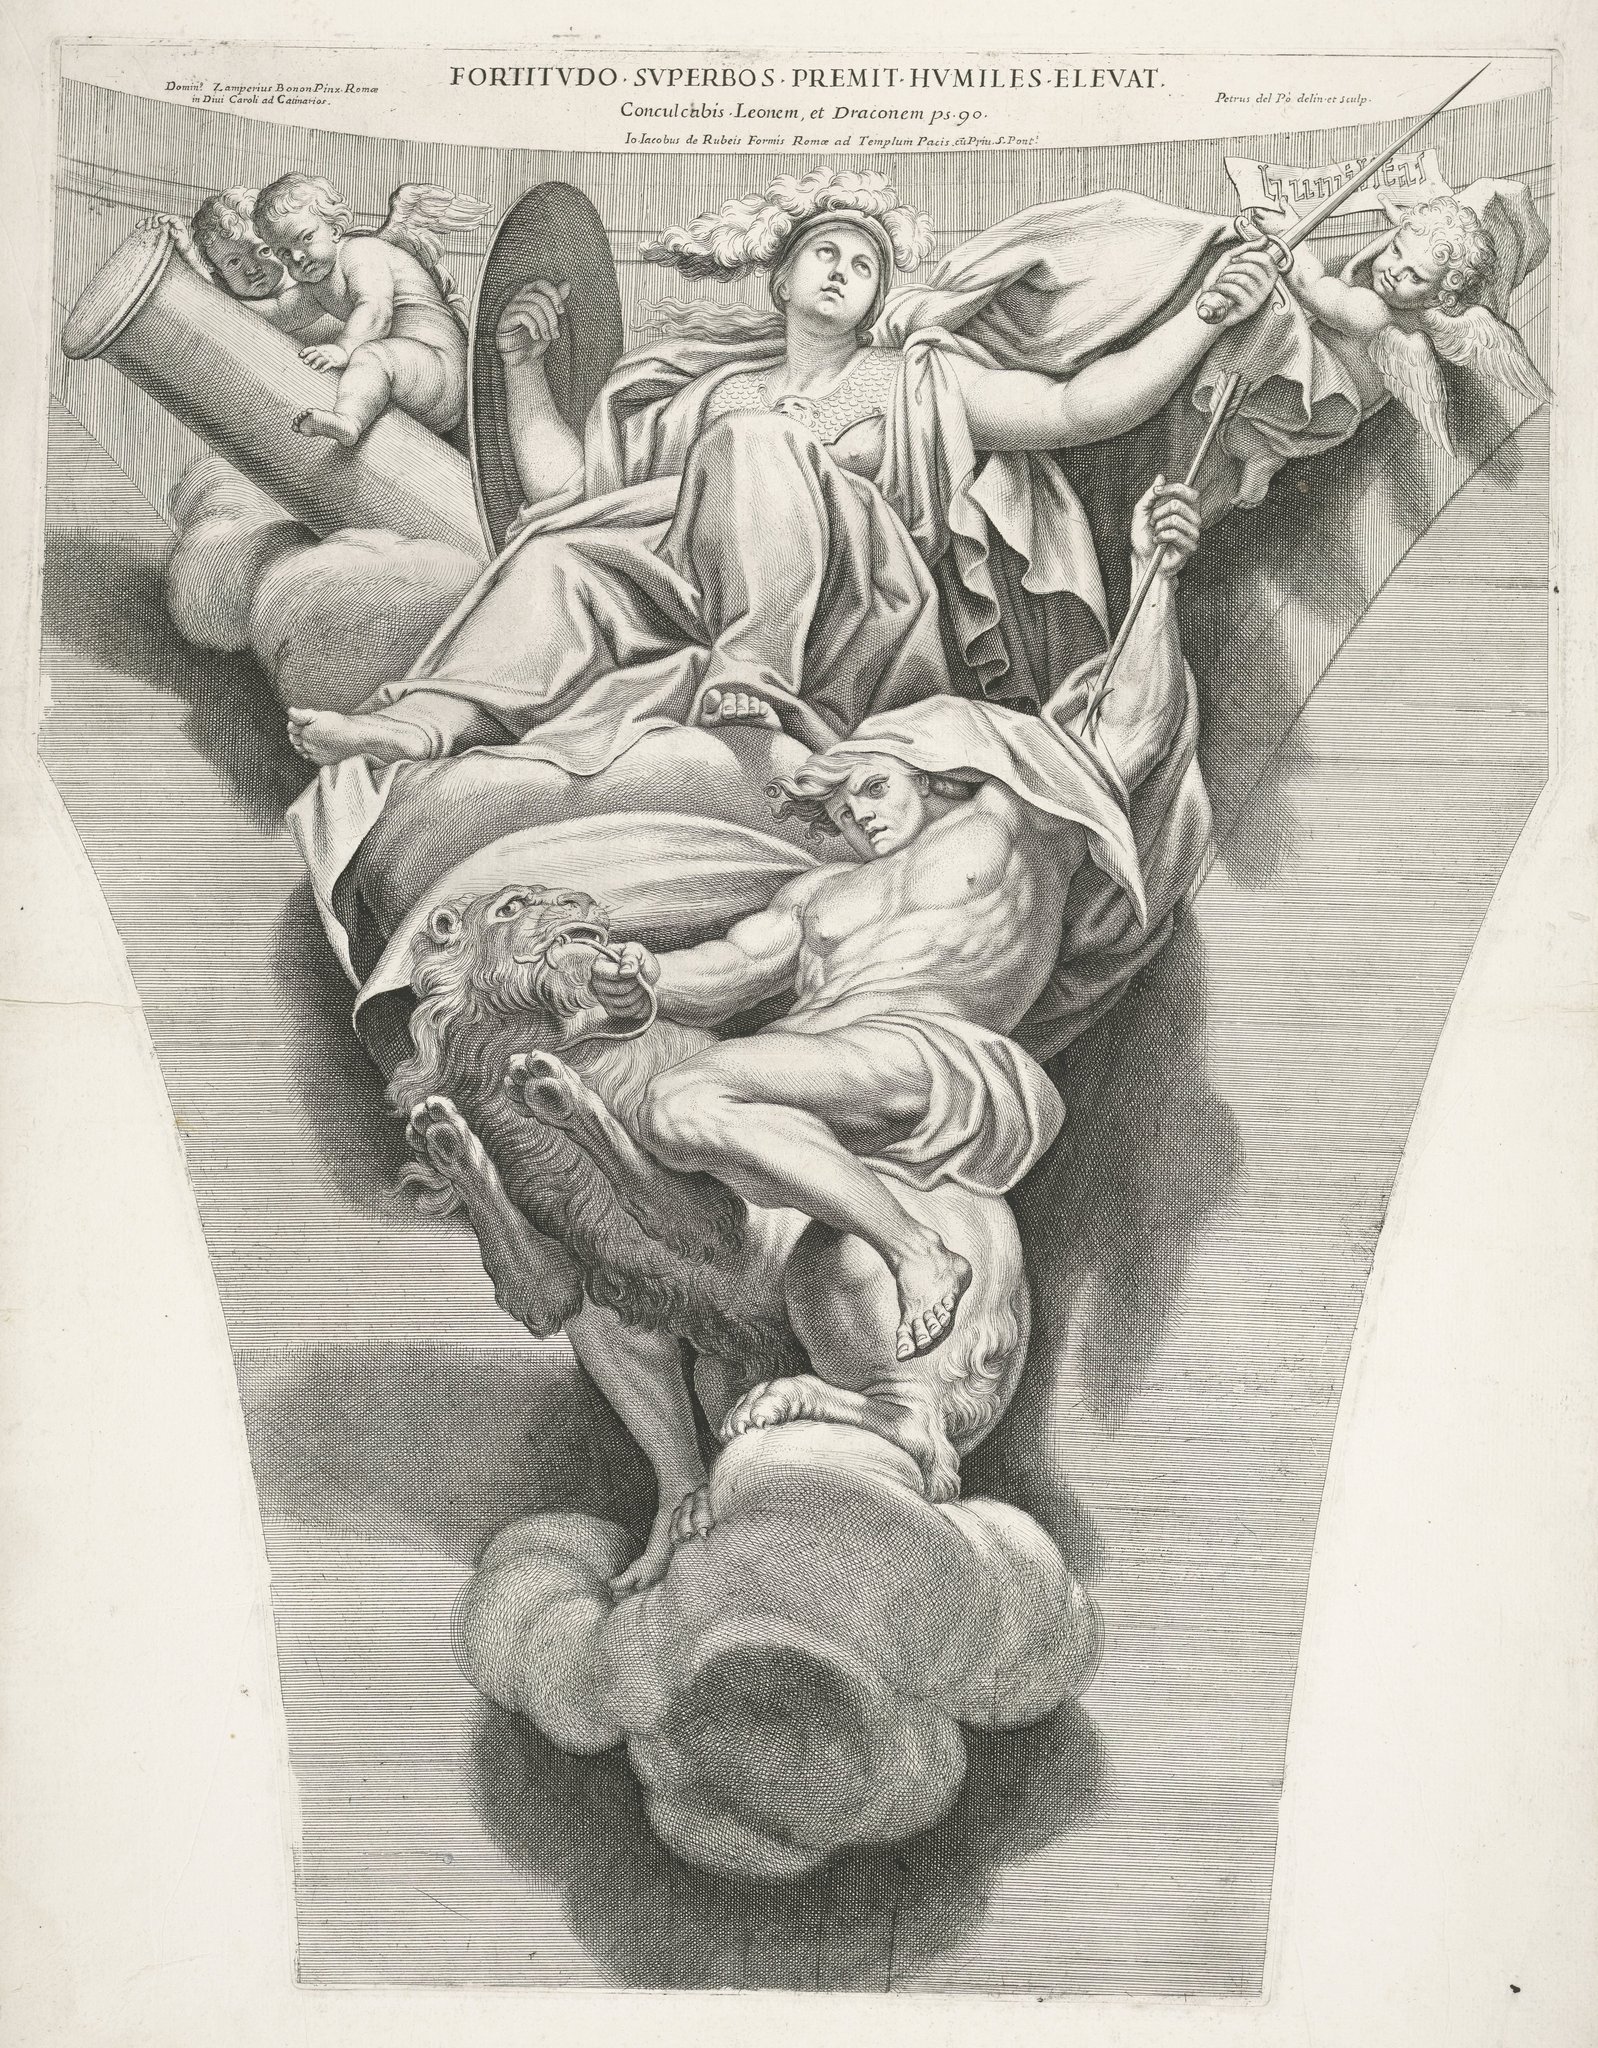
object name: print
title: Fortitudo superbos premit humiles elevat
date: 1620-1692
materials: paper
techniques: engraving, etching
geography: rome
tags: fortitude, 'fortitudo' ~ one of the four cardinal virtues, beasts of prey, predatory animals: lion, cupids: 'amores', 'amoretti', 'putti'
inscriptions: collector's mark: Lugt 240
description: Prent uit een reeks van vier prenten naar de fresco's door Domenichino in de pendentieven onder de koepel van de San Carlo ai Catinari te Rome. Getekende voorstudies door Del Po worden bewaard in Windsor Castle te Windsor.